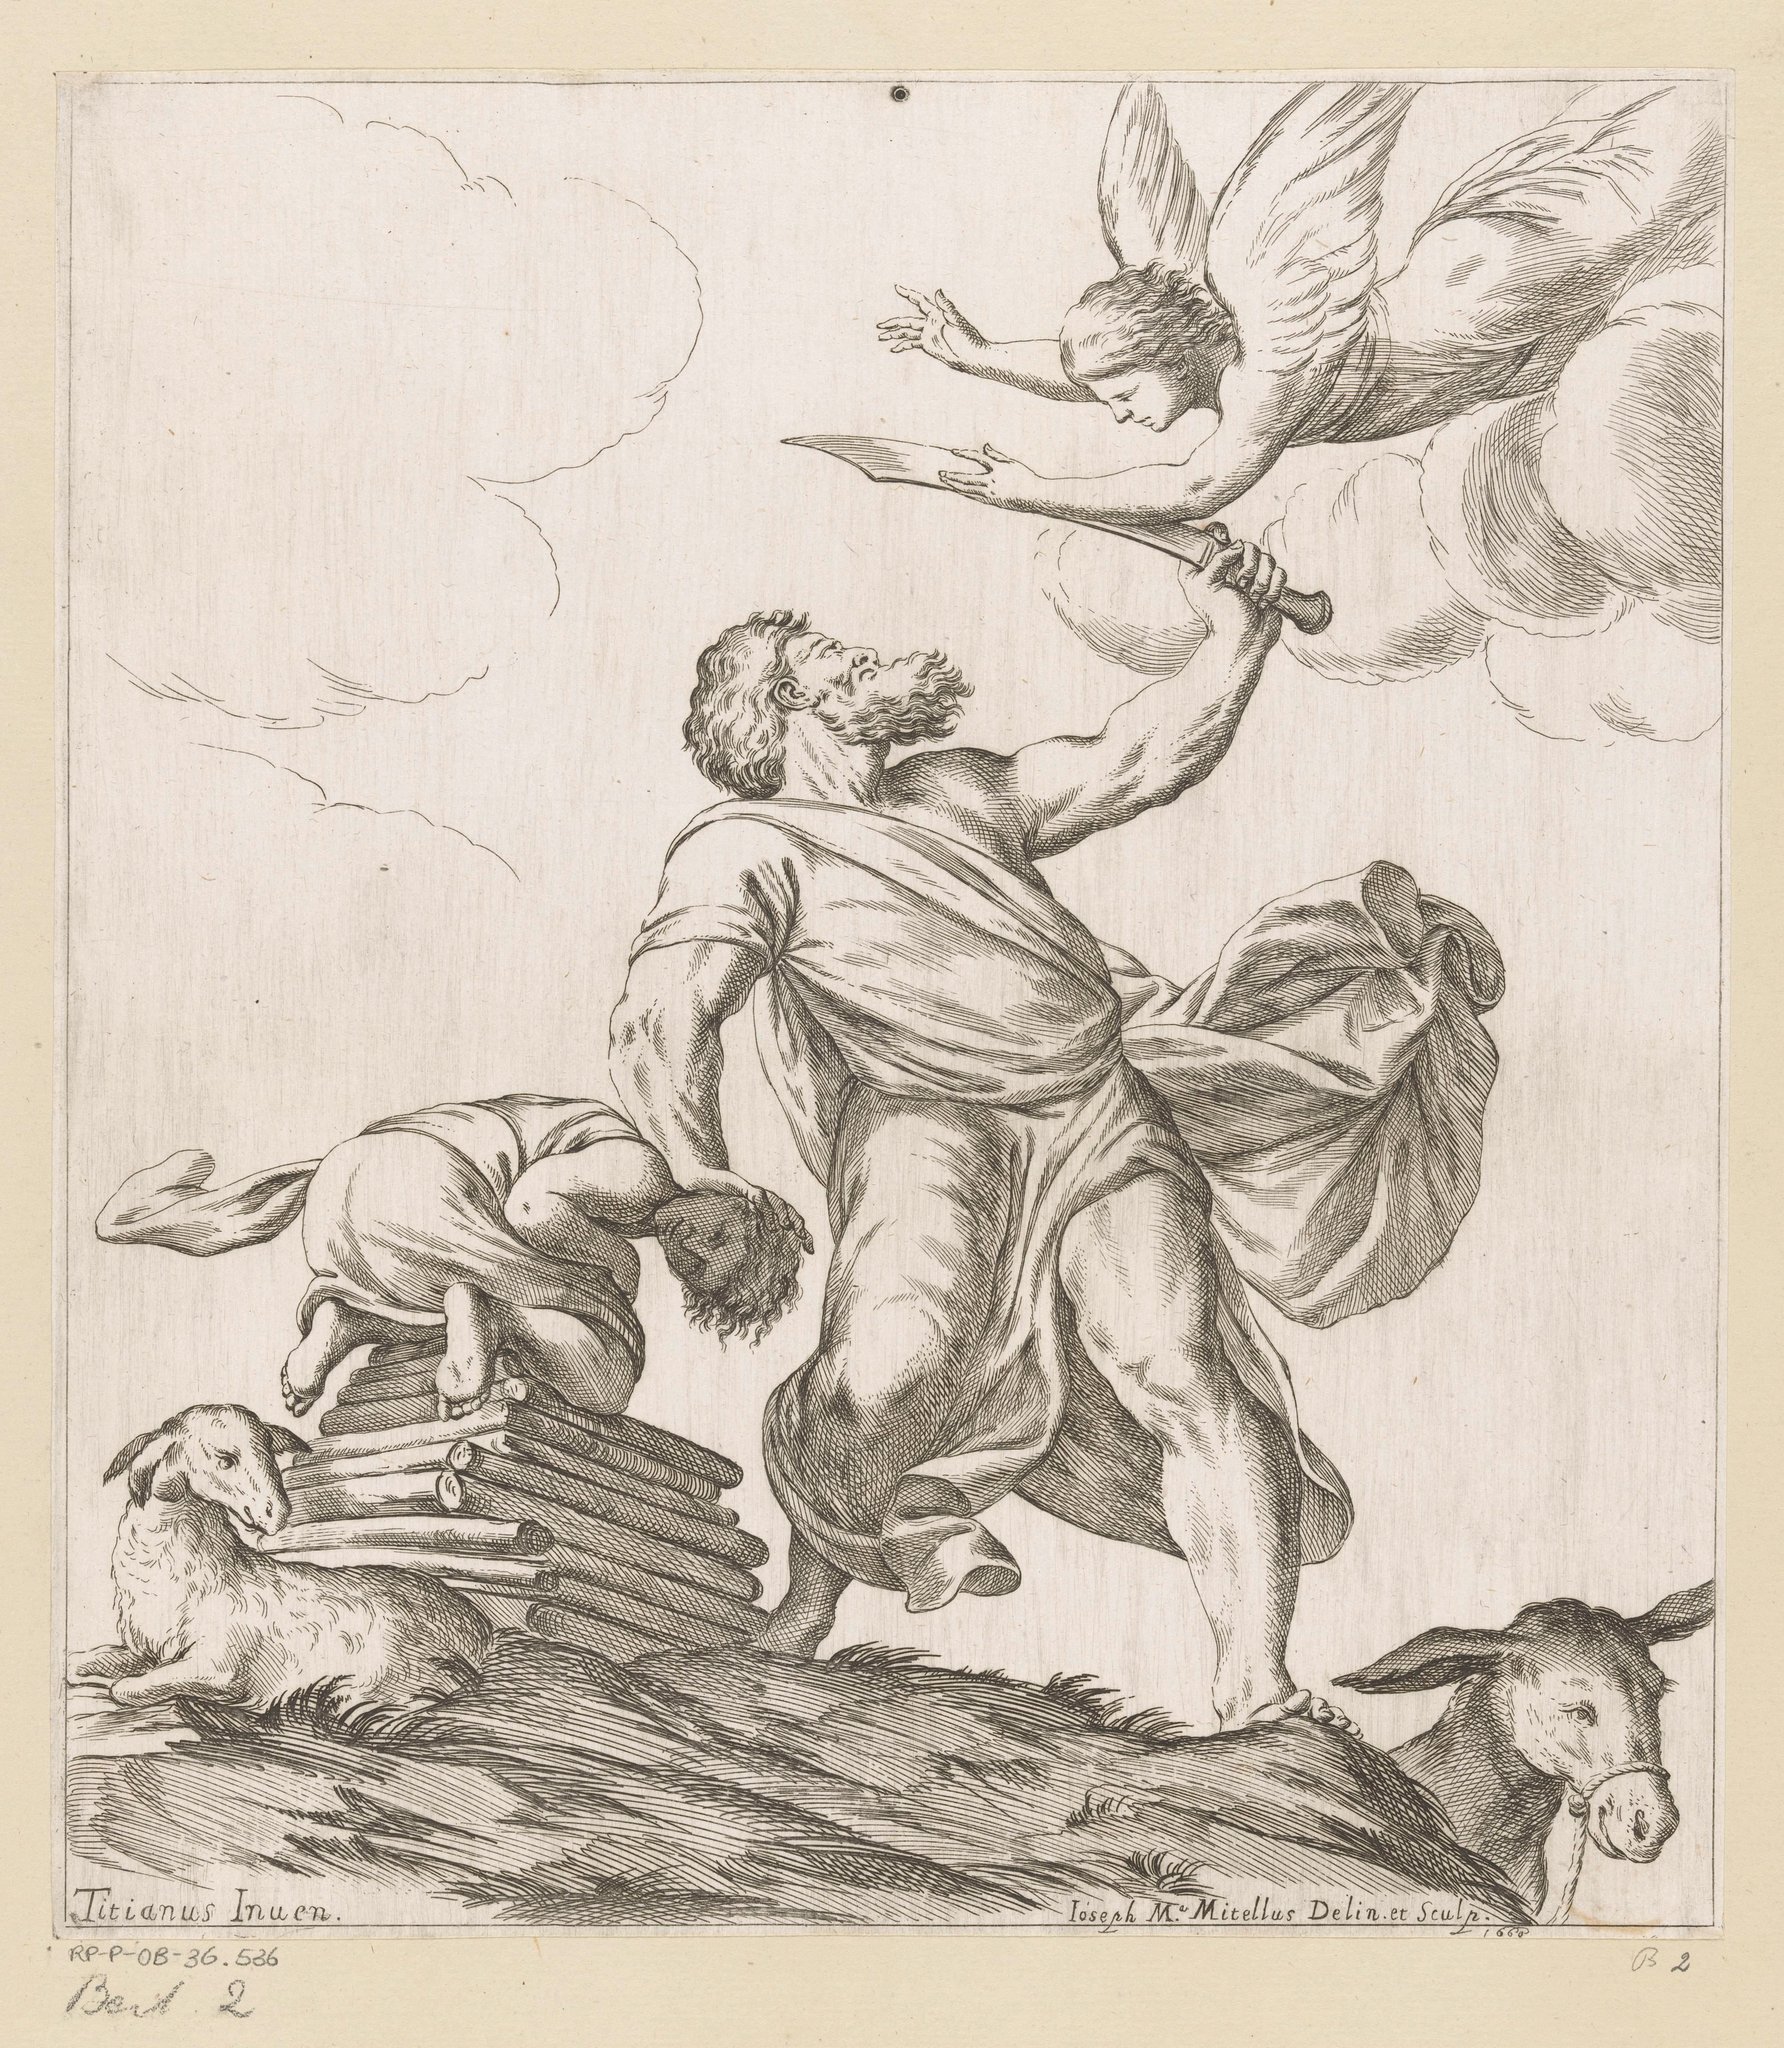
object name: print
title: Offer van Isaak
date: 1668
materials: paper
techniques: etching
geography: italy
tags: the sacrifice of isaac (genesis 22)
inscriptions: collector's mark: Lugt 240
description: Een engel houdt Abraham tegen die op het punt staat om zijn zoon Isaak te offeren.